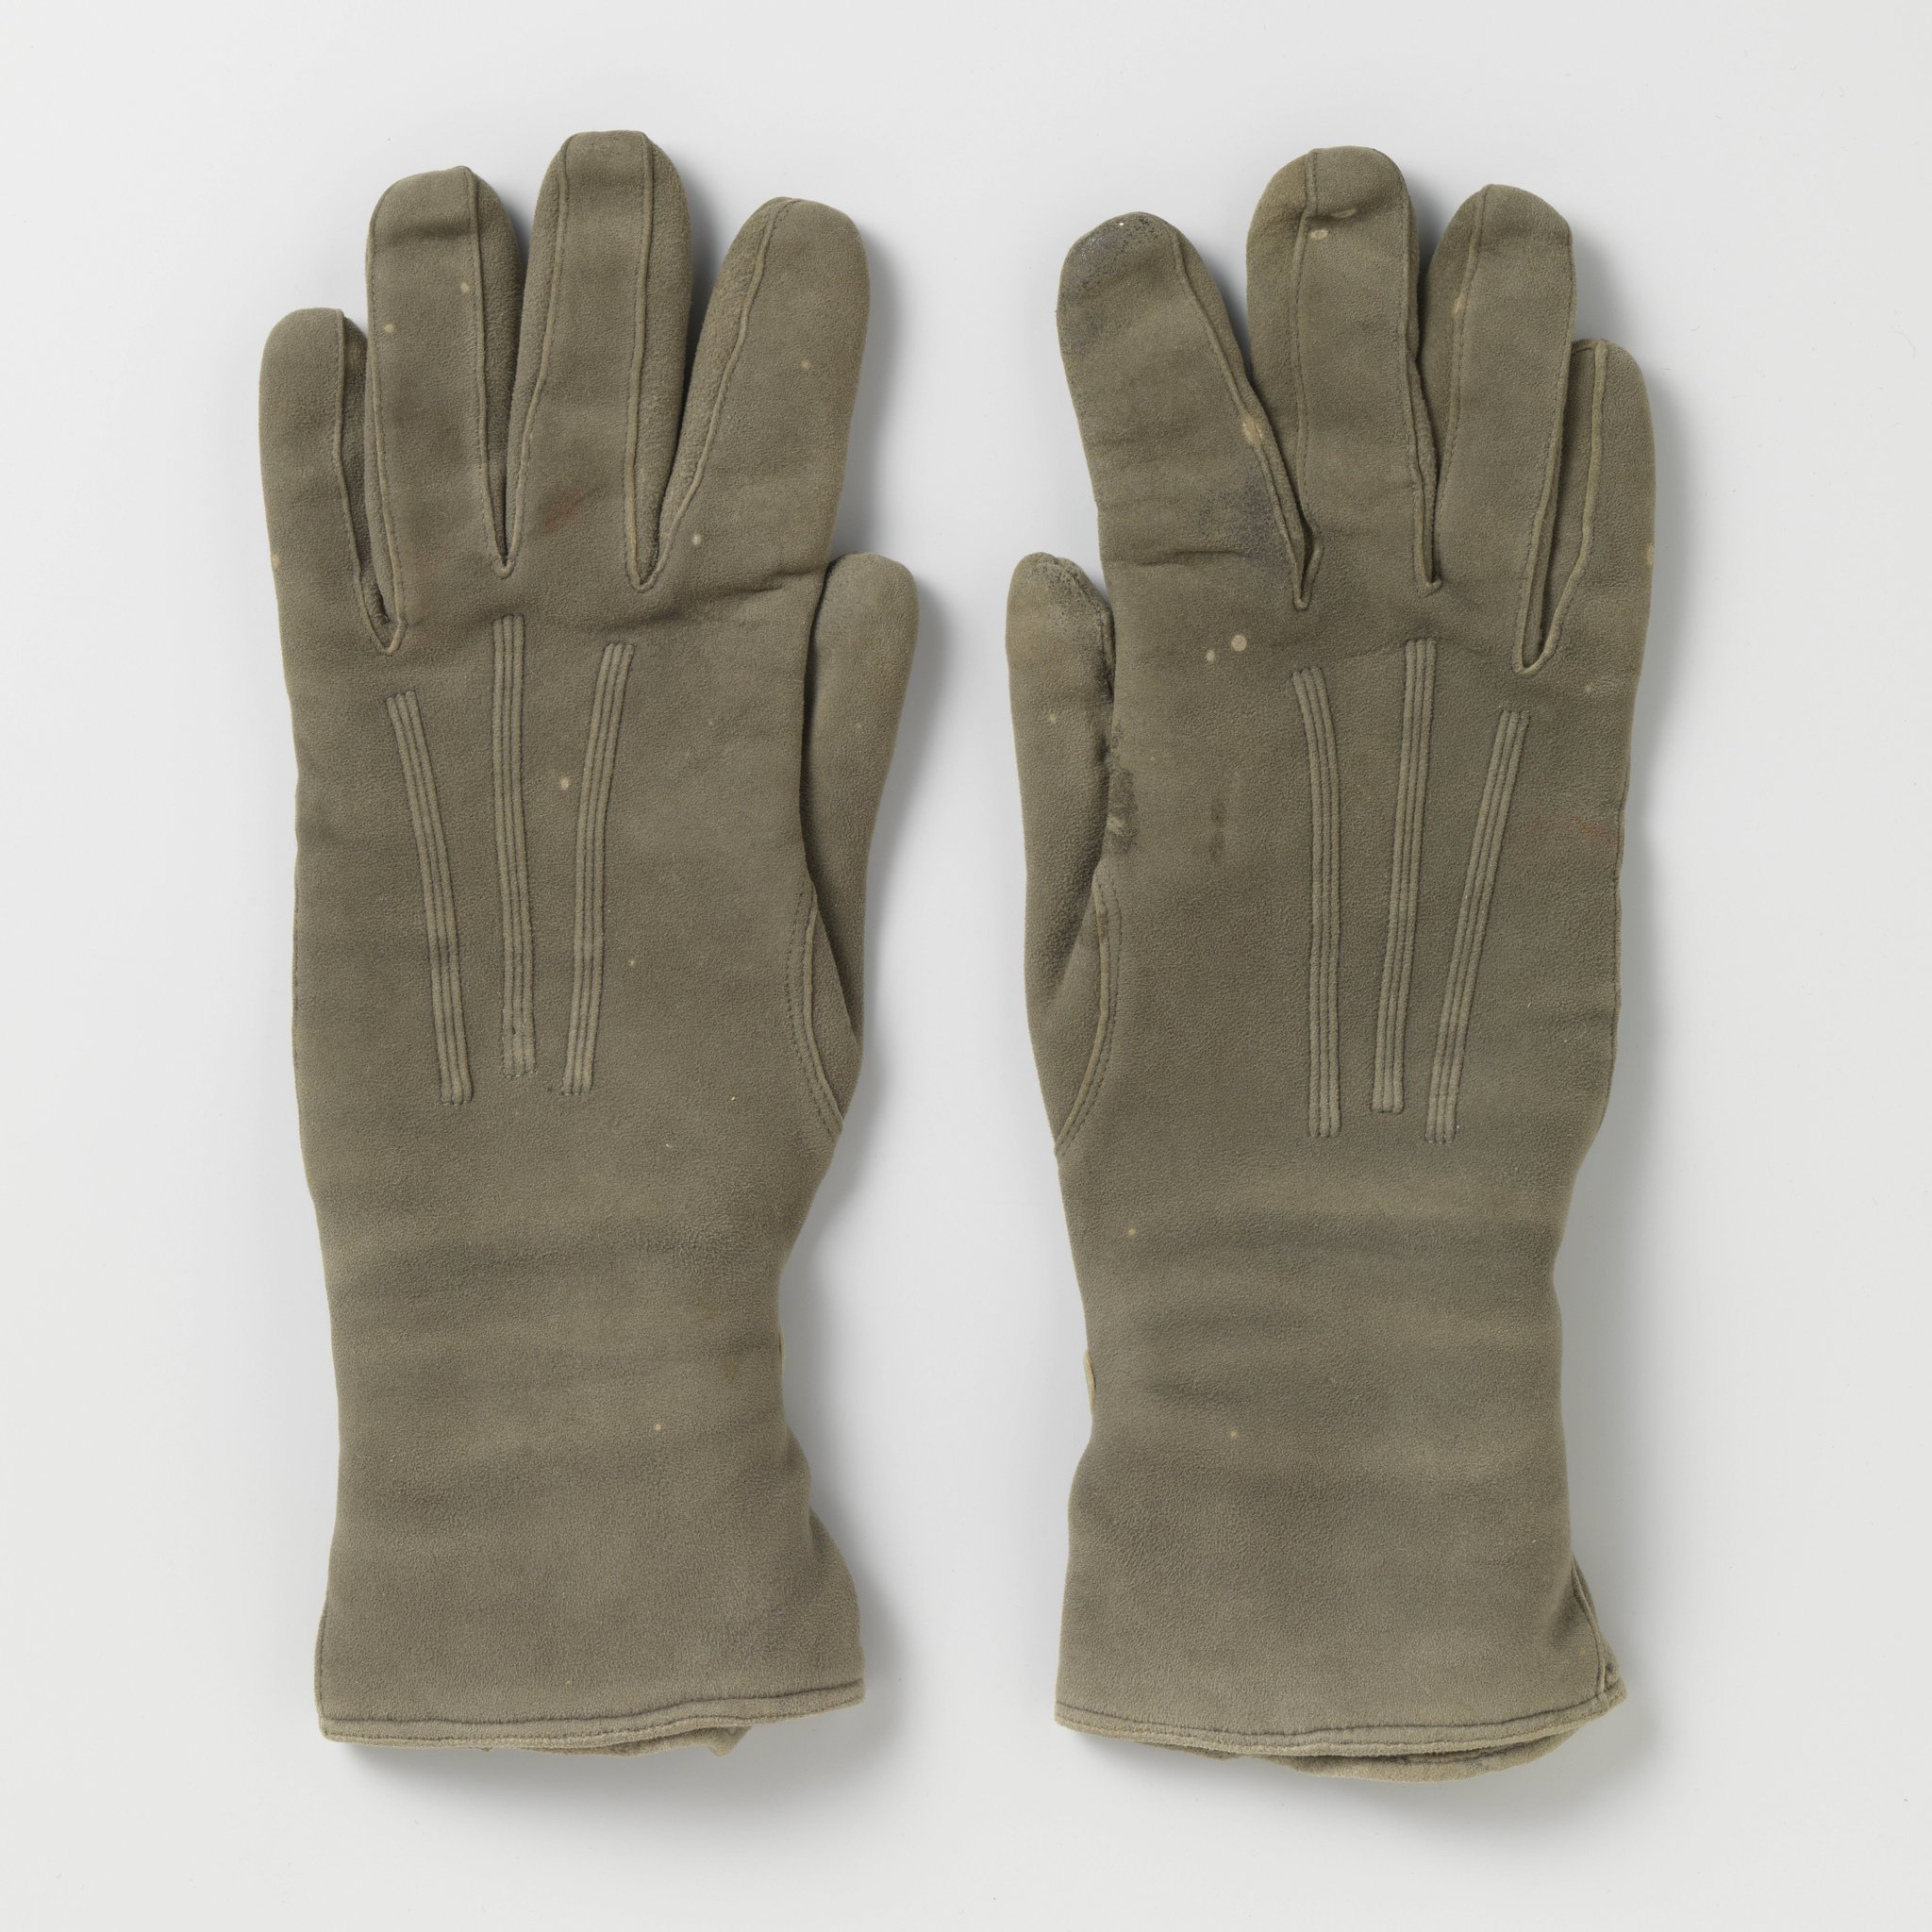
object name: clothing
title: Rechterhandschoen van grijs zeemleer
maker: m. laimböck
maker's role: modehuis, modewarenhuis, modewinkel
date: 1900-1925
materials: leather, wool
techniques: knitting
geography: netherlands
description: Rechterhandschoen van grijs zeemleer, op de rug drie uitstralende koorden. Gevoerd met beige gebreide wol. Om de pols een bandje met drukknoop om de handschoen dicht te maken.